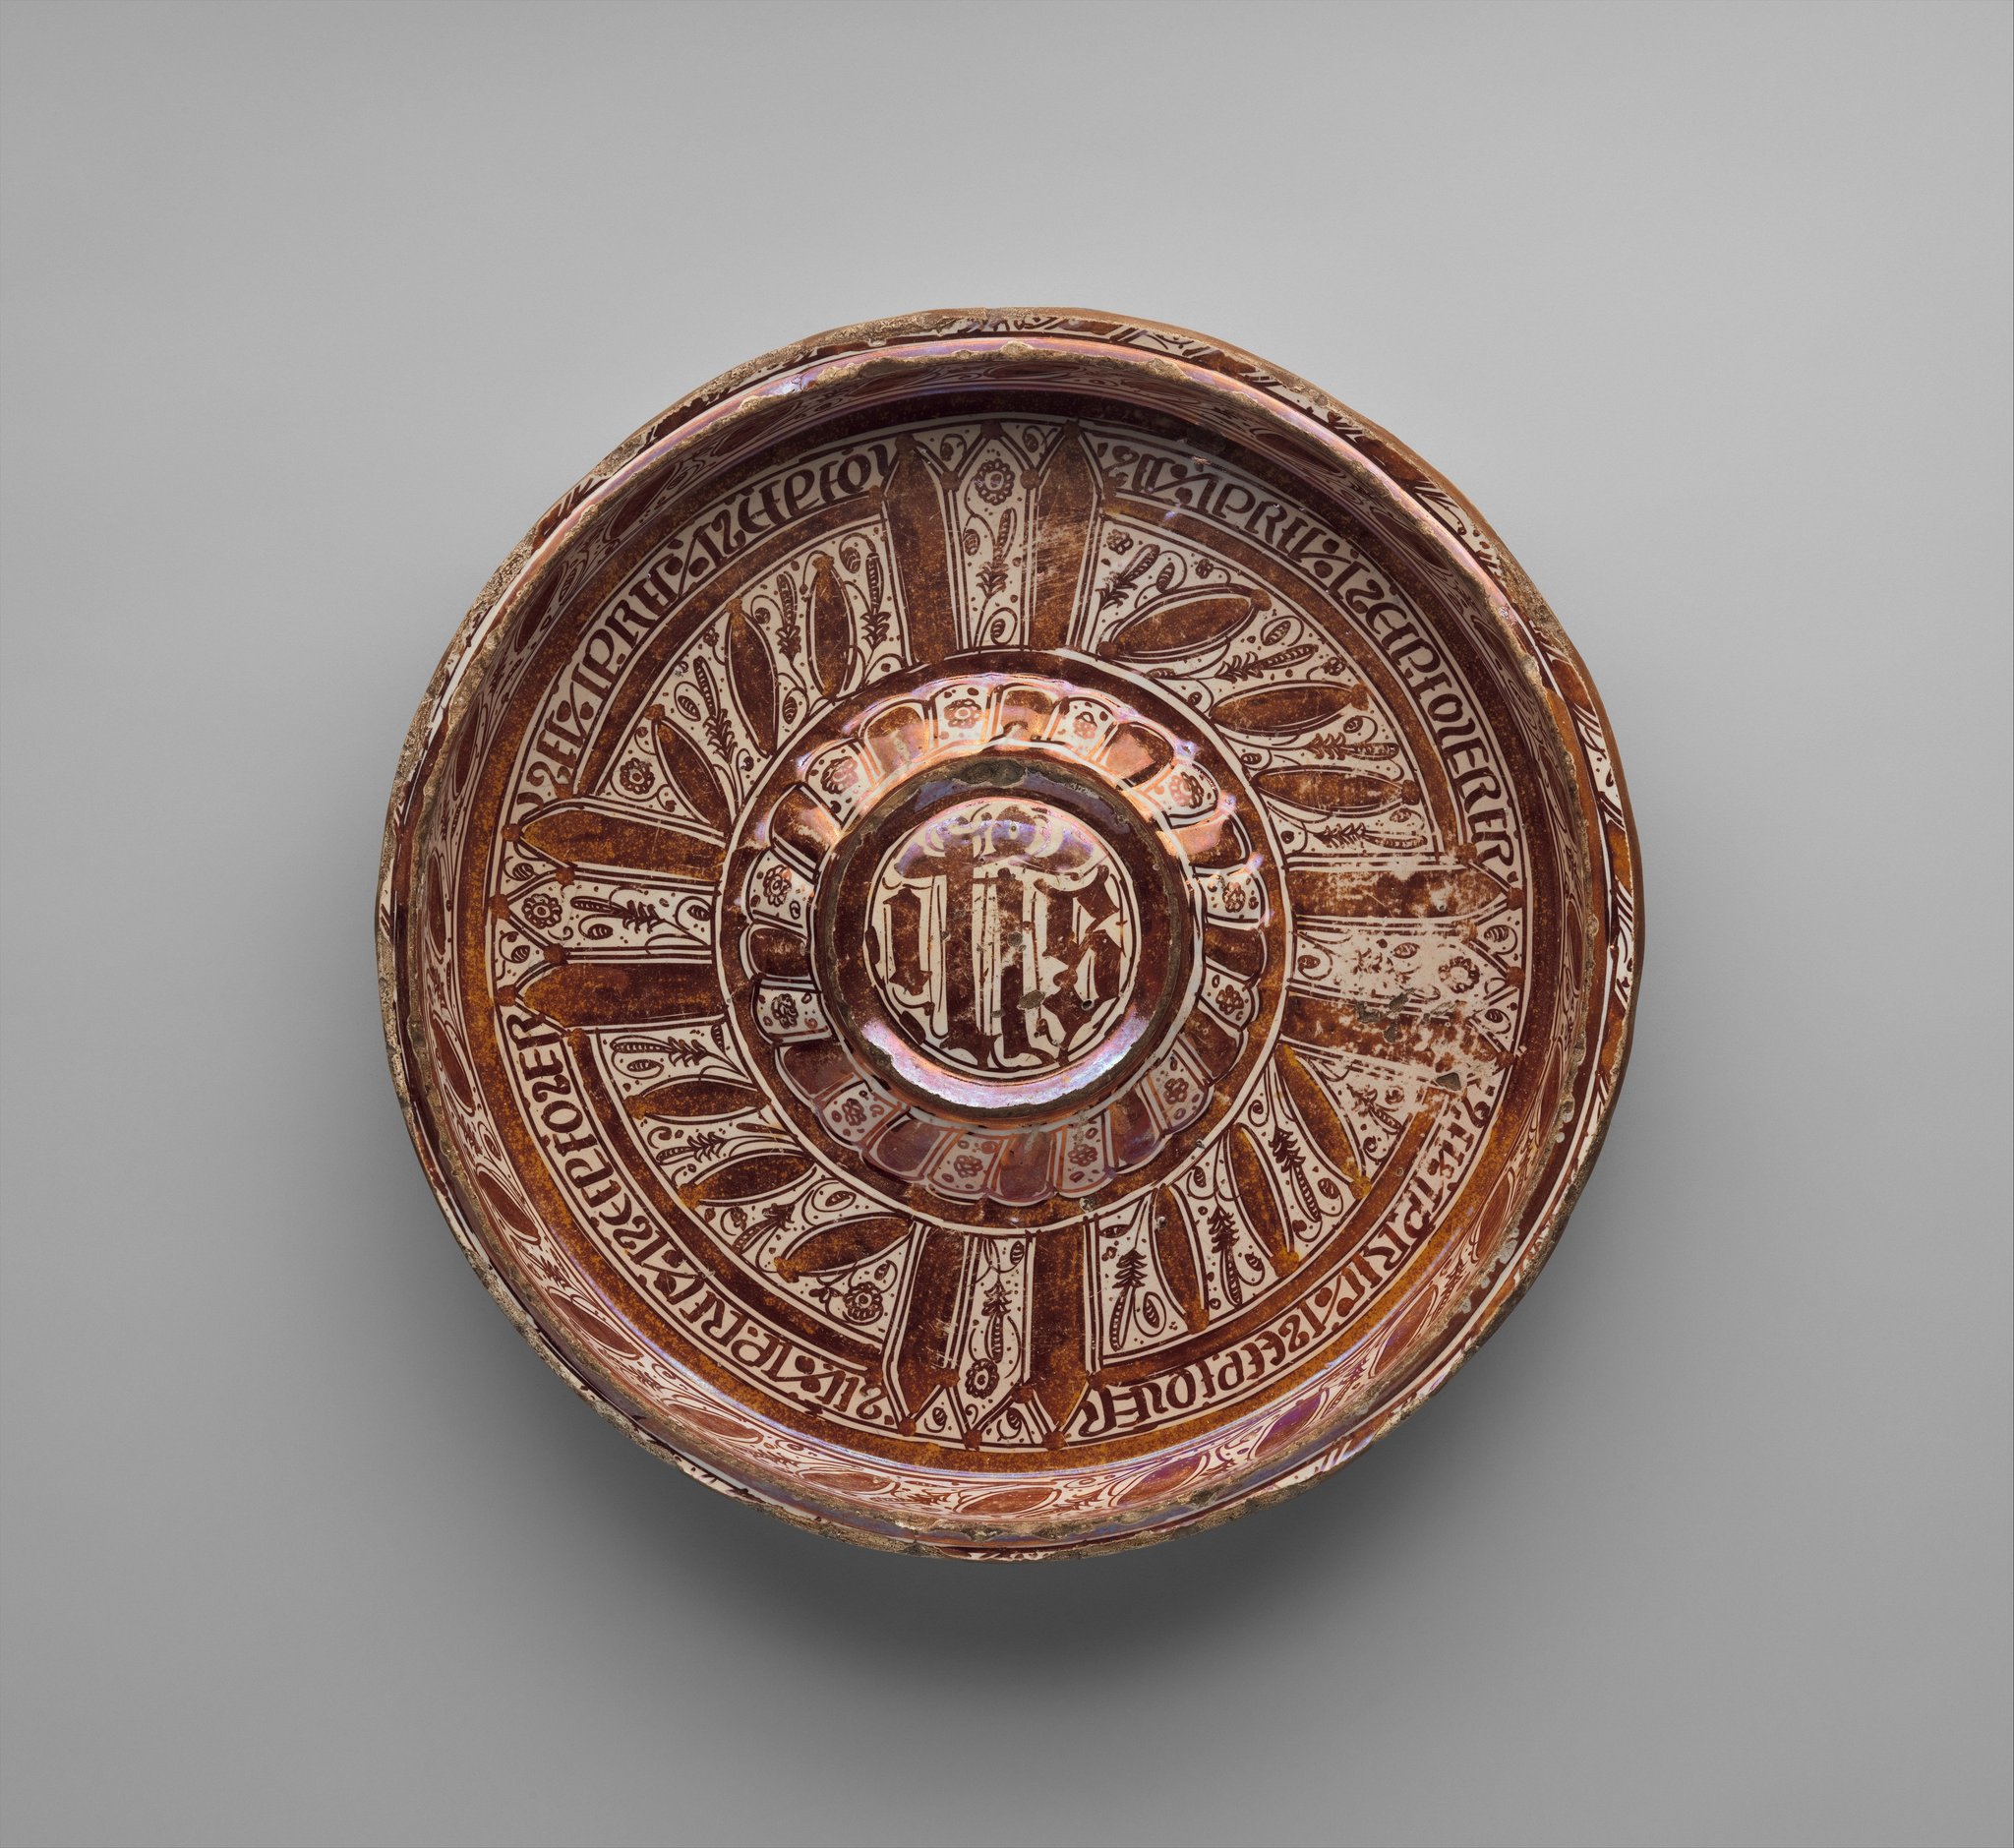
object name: dish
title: Deep Dish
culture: spanish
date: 1501-1550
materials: earthenware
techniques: glazing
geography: spain